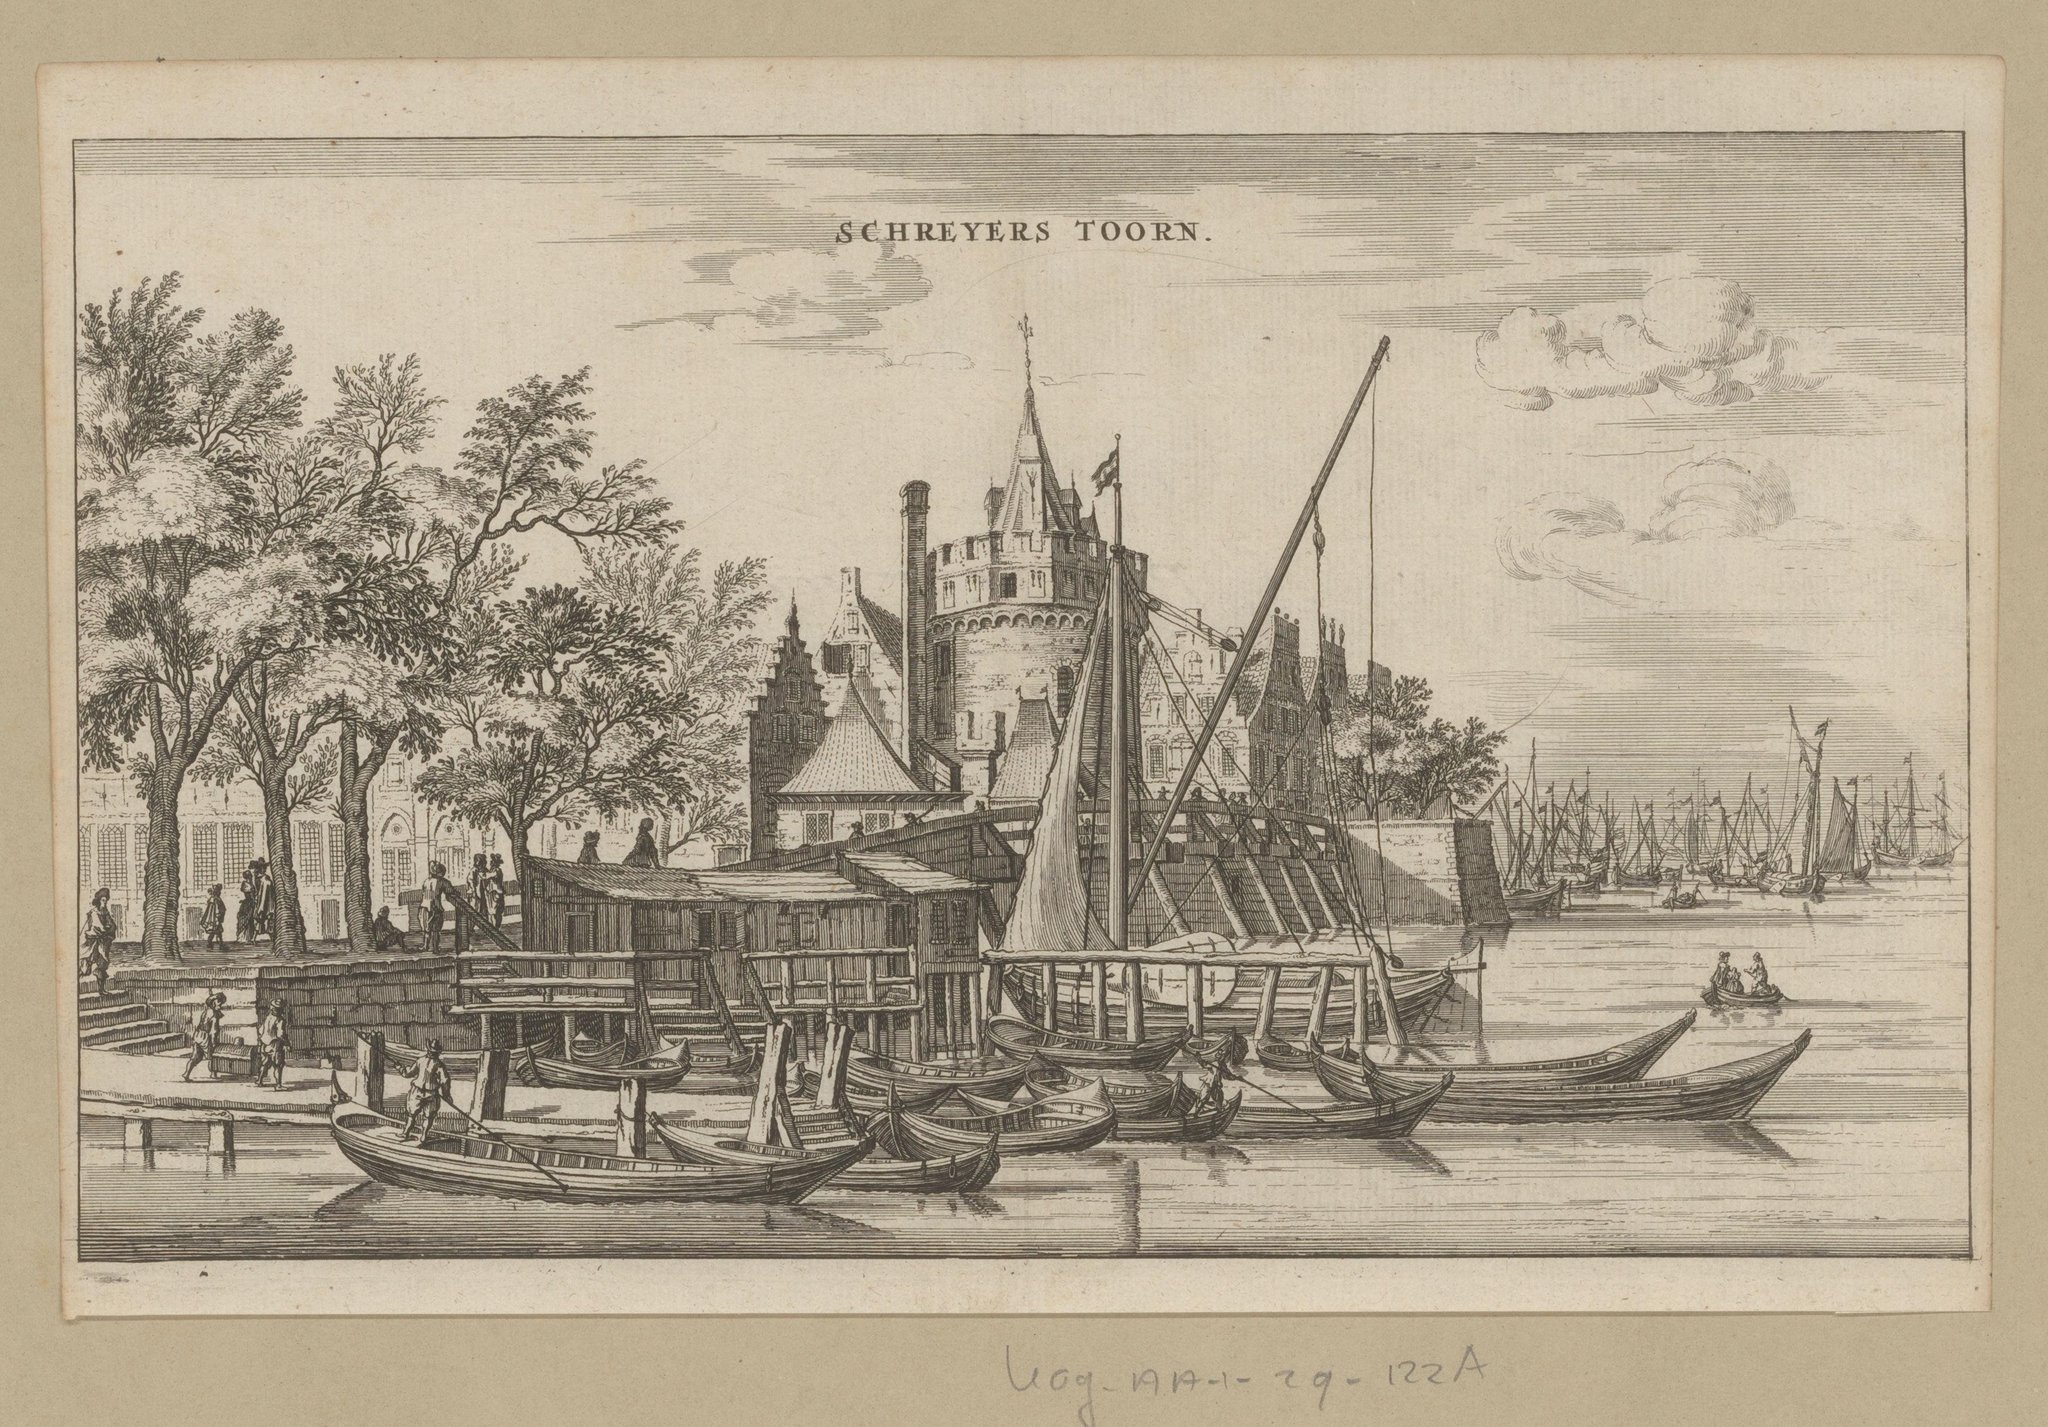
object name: print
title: Gezicht op de Schreierstoren te Amsterdam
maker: jacob van meurs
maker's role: draughtsman, print maker, publisher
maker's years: 1619-1680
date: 1663-1664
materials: paper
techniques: engraving, etching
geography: amsterdam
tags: sailing-ship, sailing-boat, towers ~ fortified city, rowing-boat, canoe, etc., canals, waters (in city) (+ city(-scape) with figures, staffage)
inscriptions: collector's mark: Lugt 1641b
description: Prent mogelijk uit: Dapper, Olfert. Historische beschryving der stadt Amsterdam (…). Amsterdam: Jacob van Meurs, 1663. Of uit: Zesen, Philipp von. Beschreibung der Stadt Amsterdam (…). Amsterdam: Joachim Nosche, 1664. Bij sommige exemplaren van eerstgenoemde uitgave werd een latere staat ingebonden waarop boven de Nederlandse titel ook een Franse is toegevoegd.